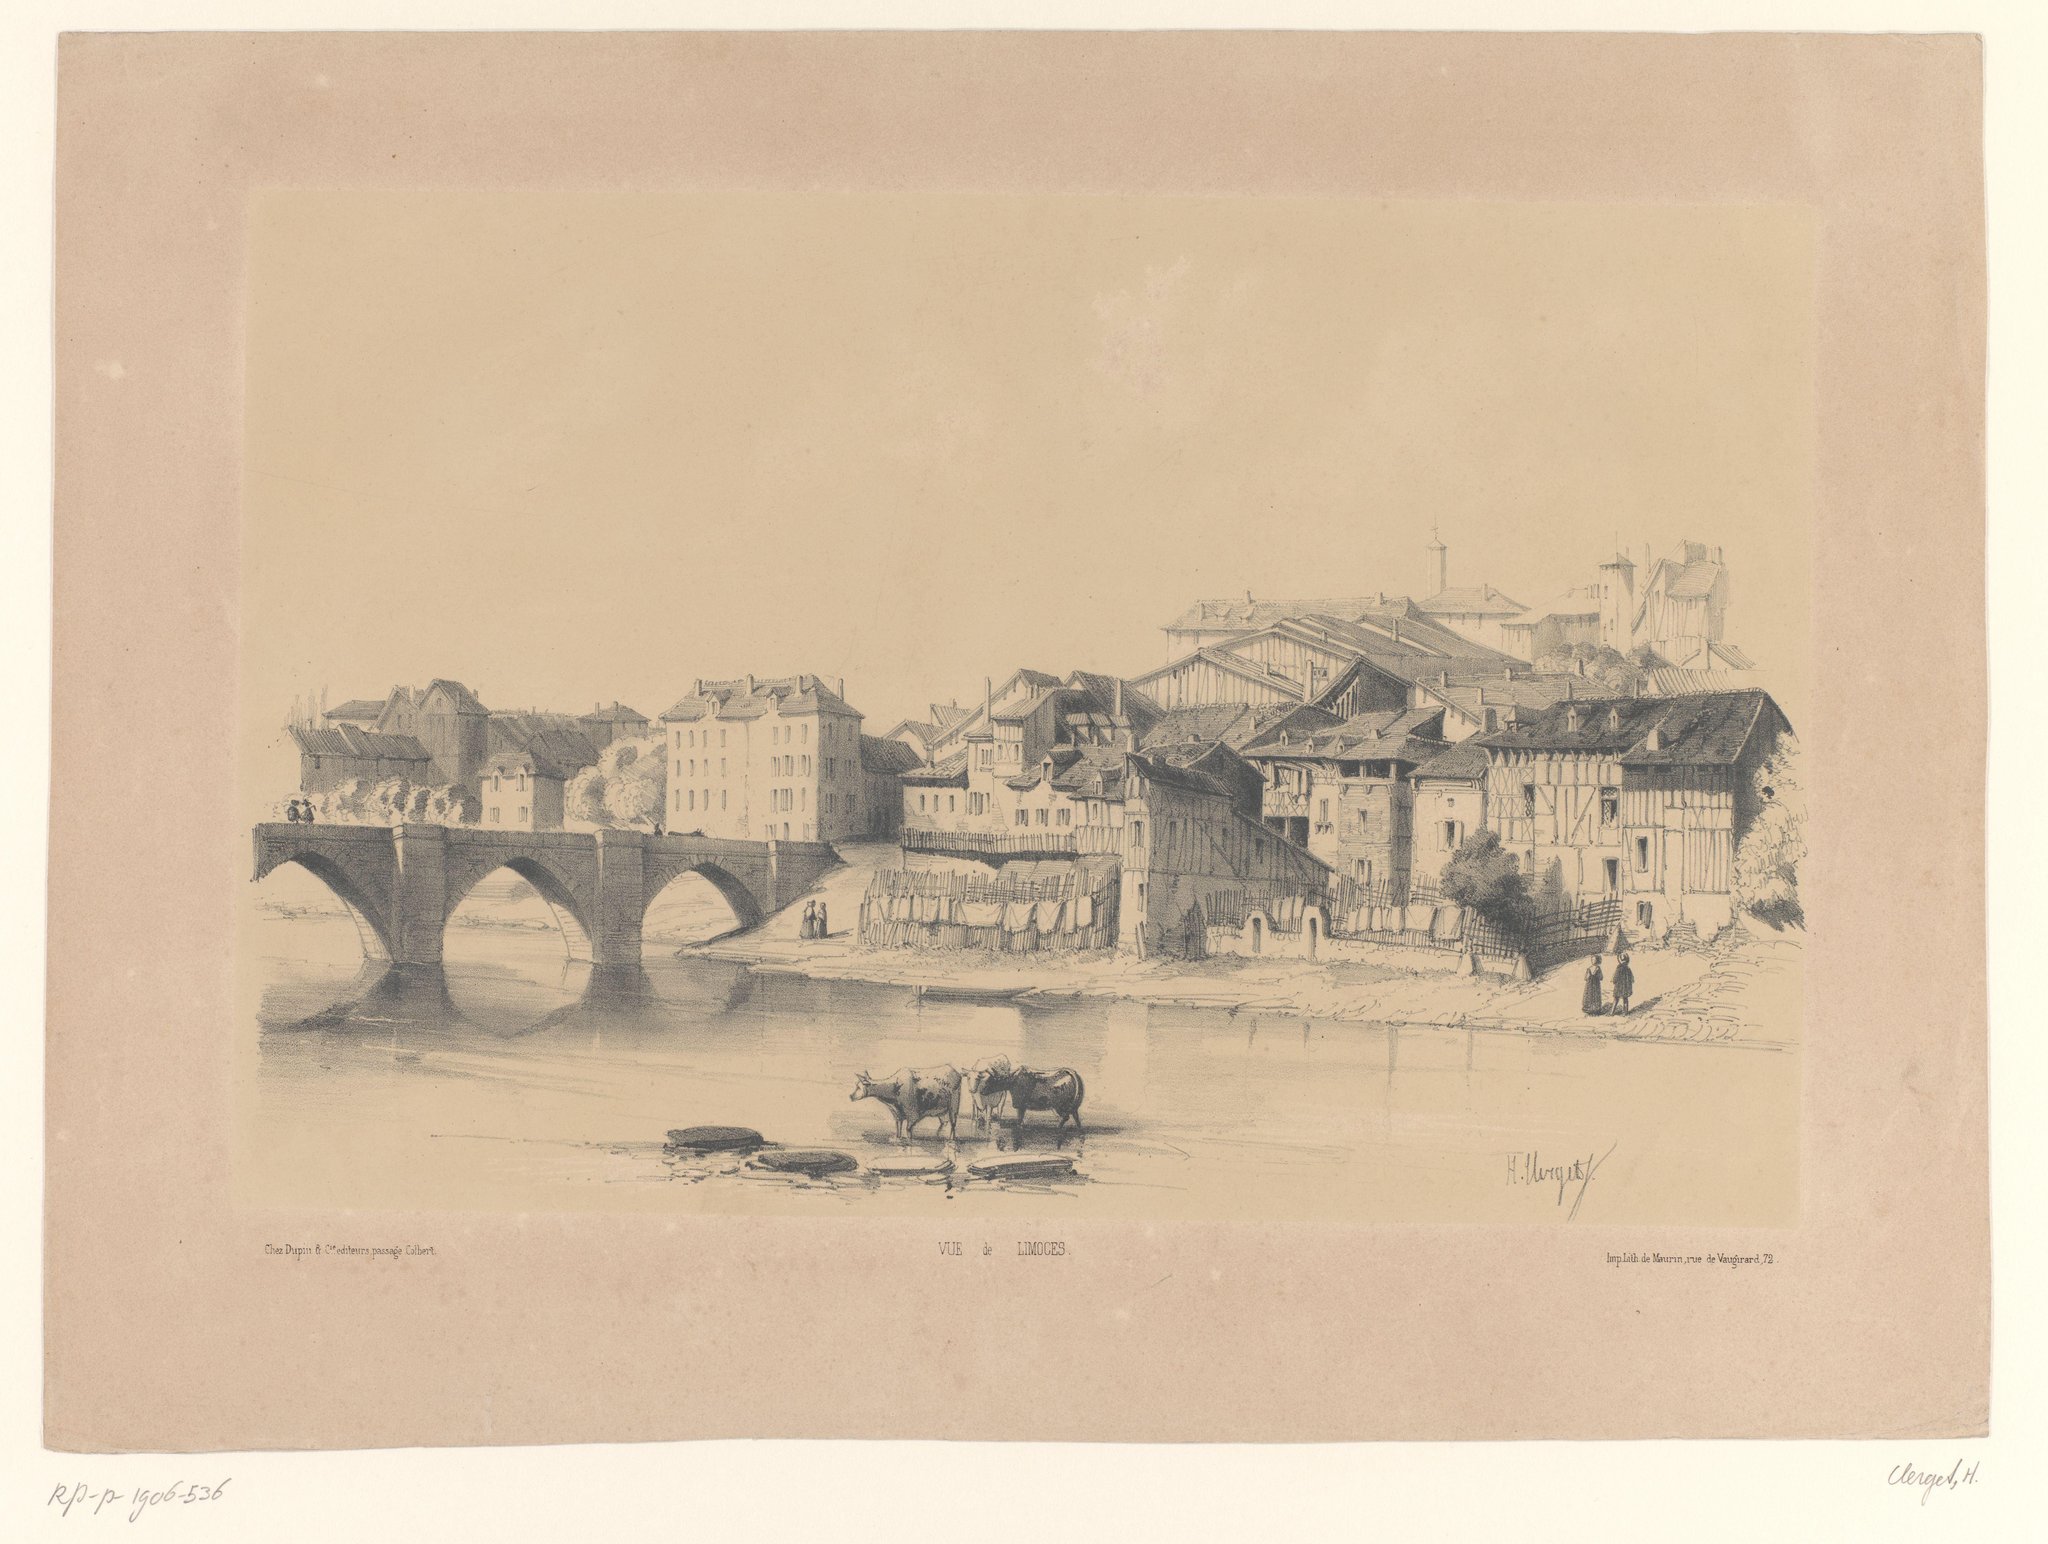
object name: print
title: Fragmenten van landschappen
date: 1840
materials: paper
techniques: tone lithography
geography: paris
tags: urban housing, bridge in city across river, canal, etc. (+ city(-scape) with figures, staffage), river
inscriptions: collector's mark: Lugt 2228a